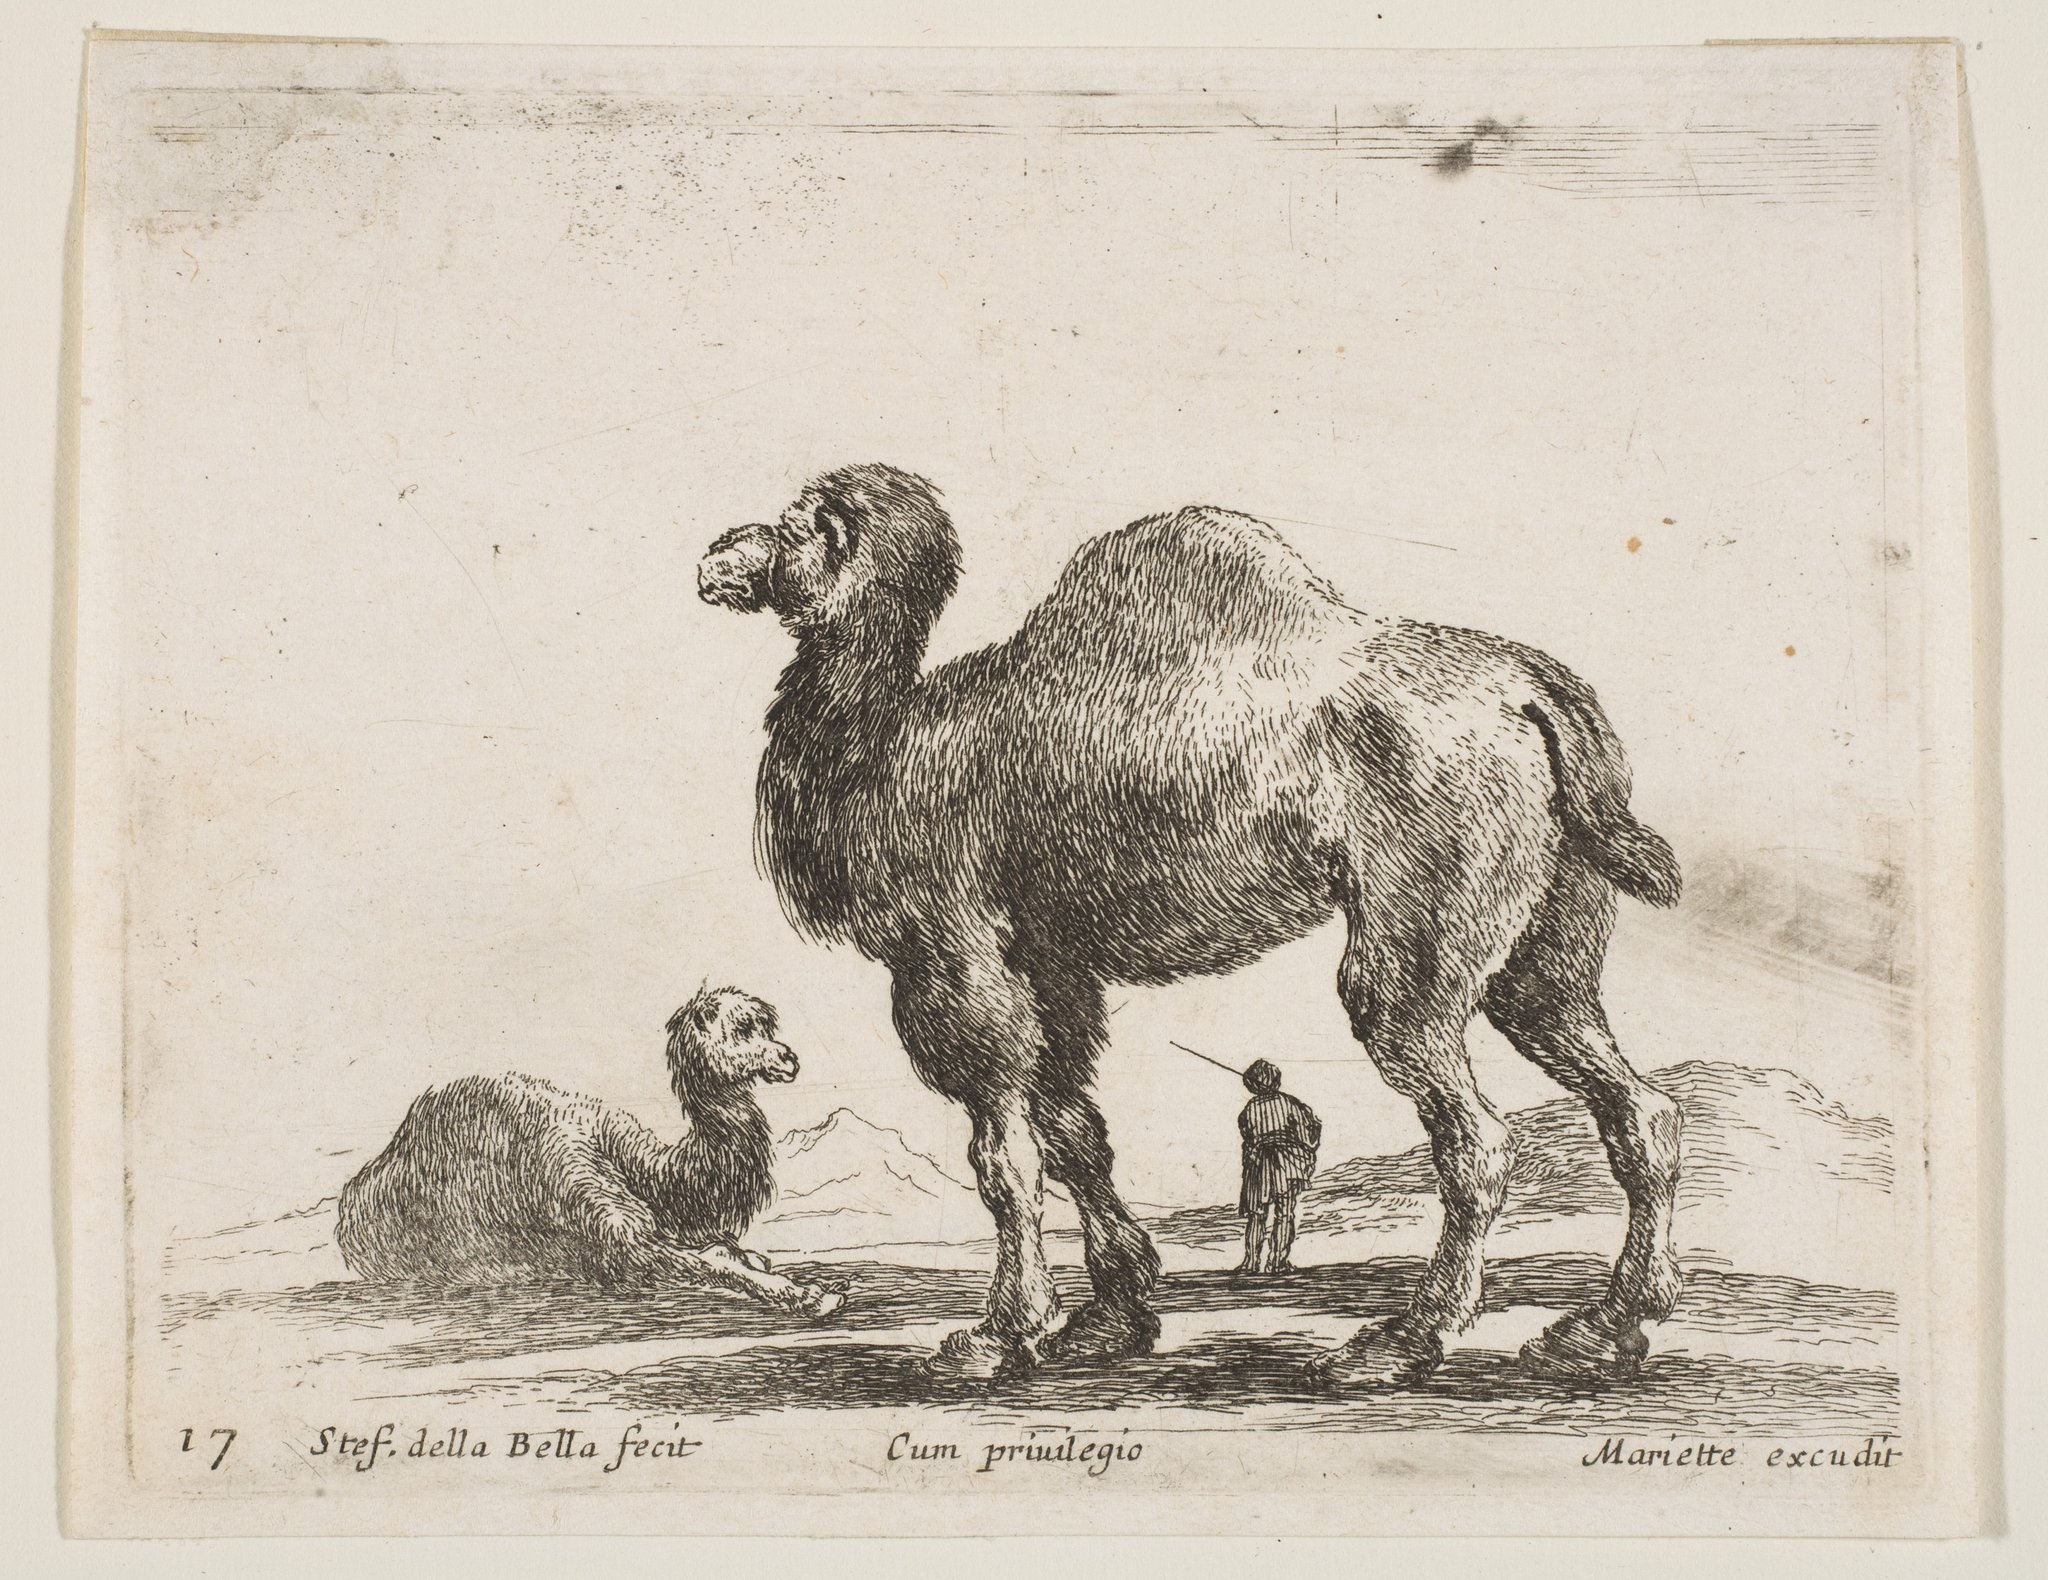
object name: print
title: Camels, plate 17 from "Various Animals" (Diversi Animali)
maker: stefano della bella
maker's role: artist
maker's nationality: italian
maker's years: 1610-1664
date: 1641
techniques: etching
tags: camels